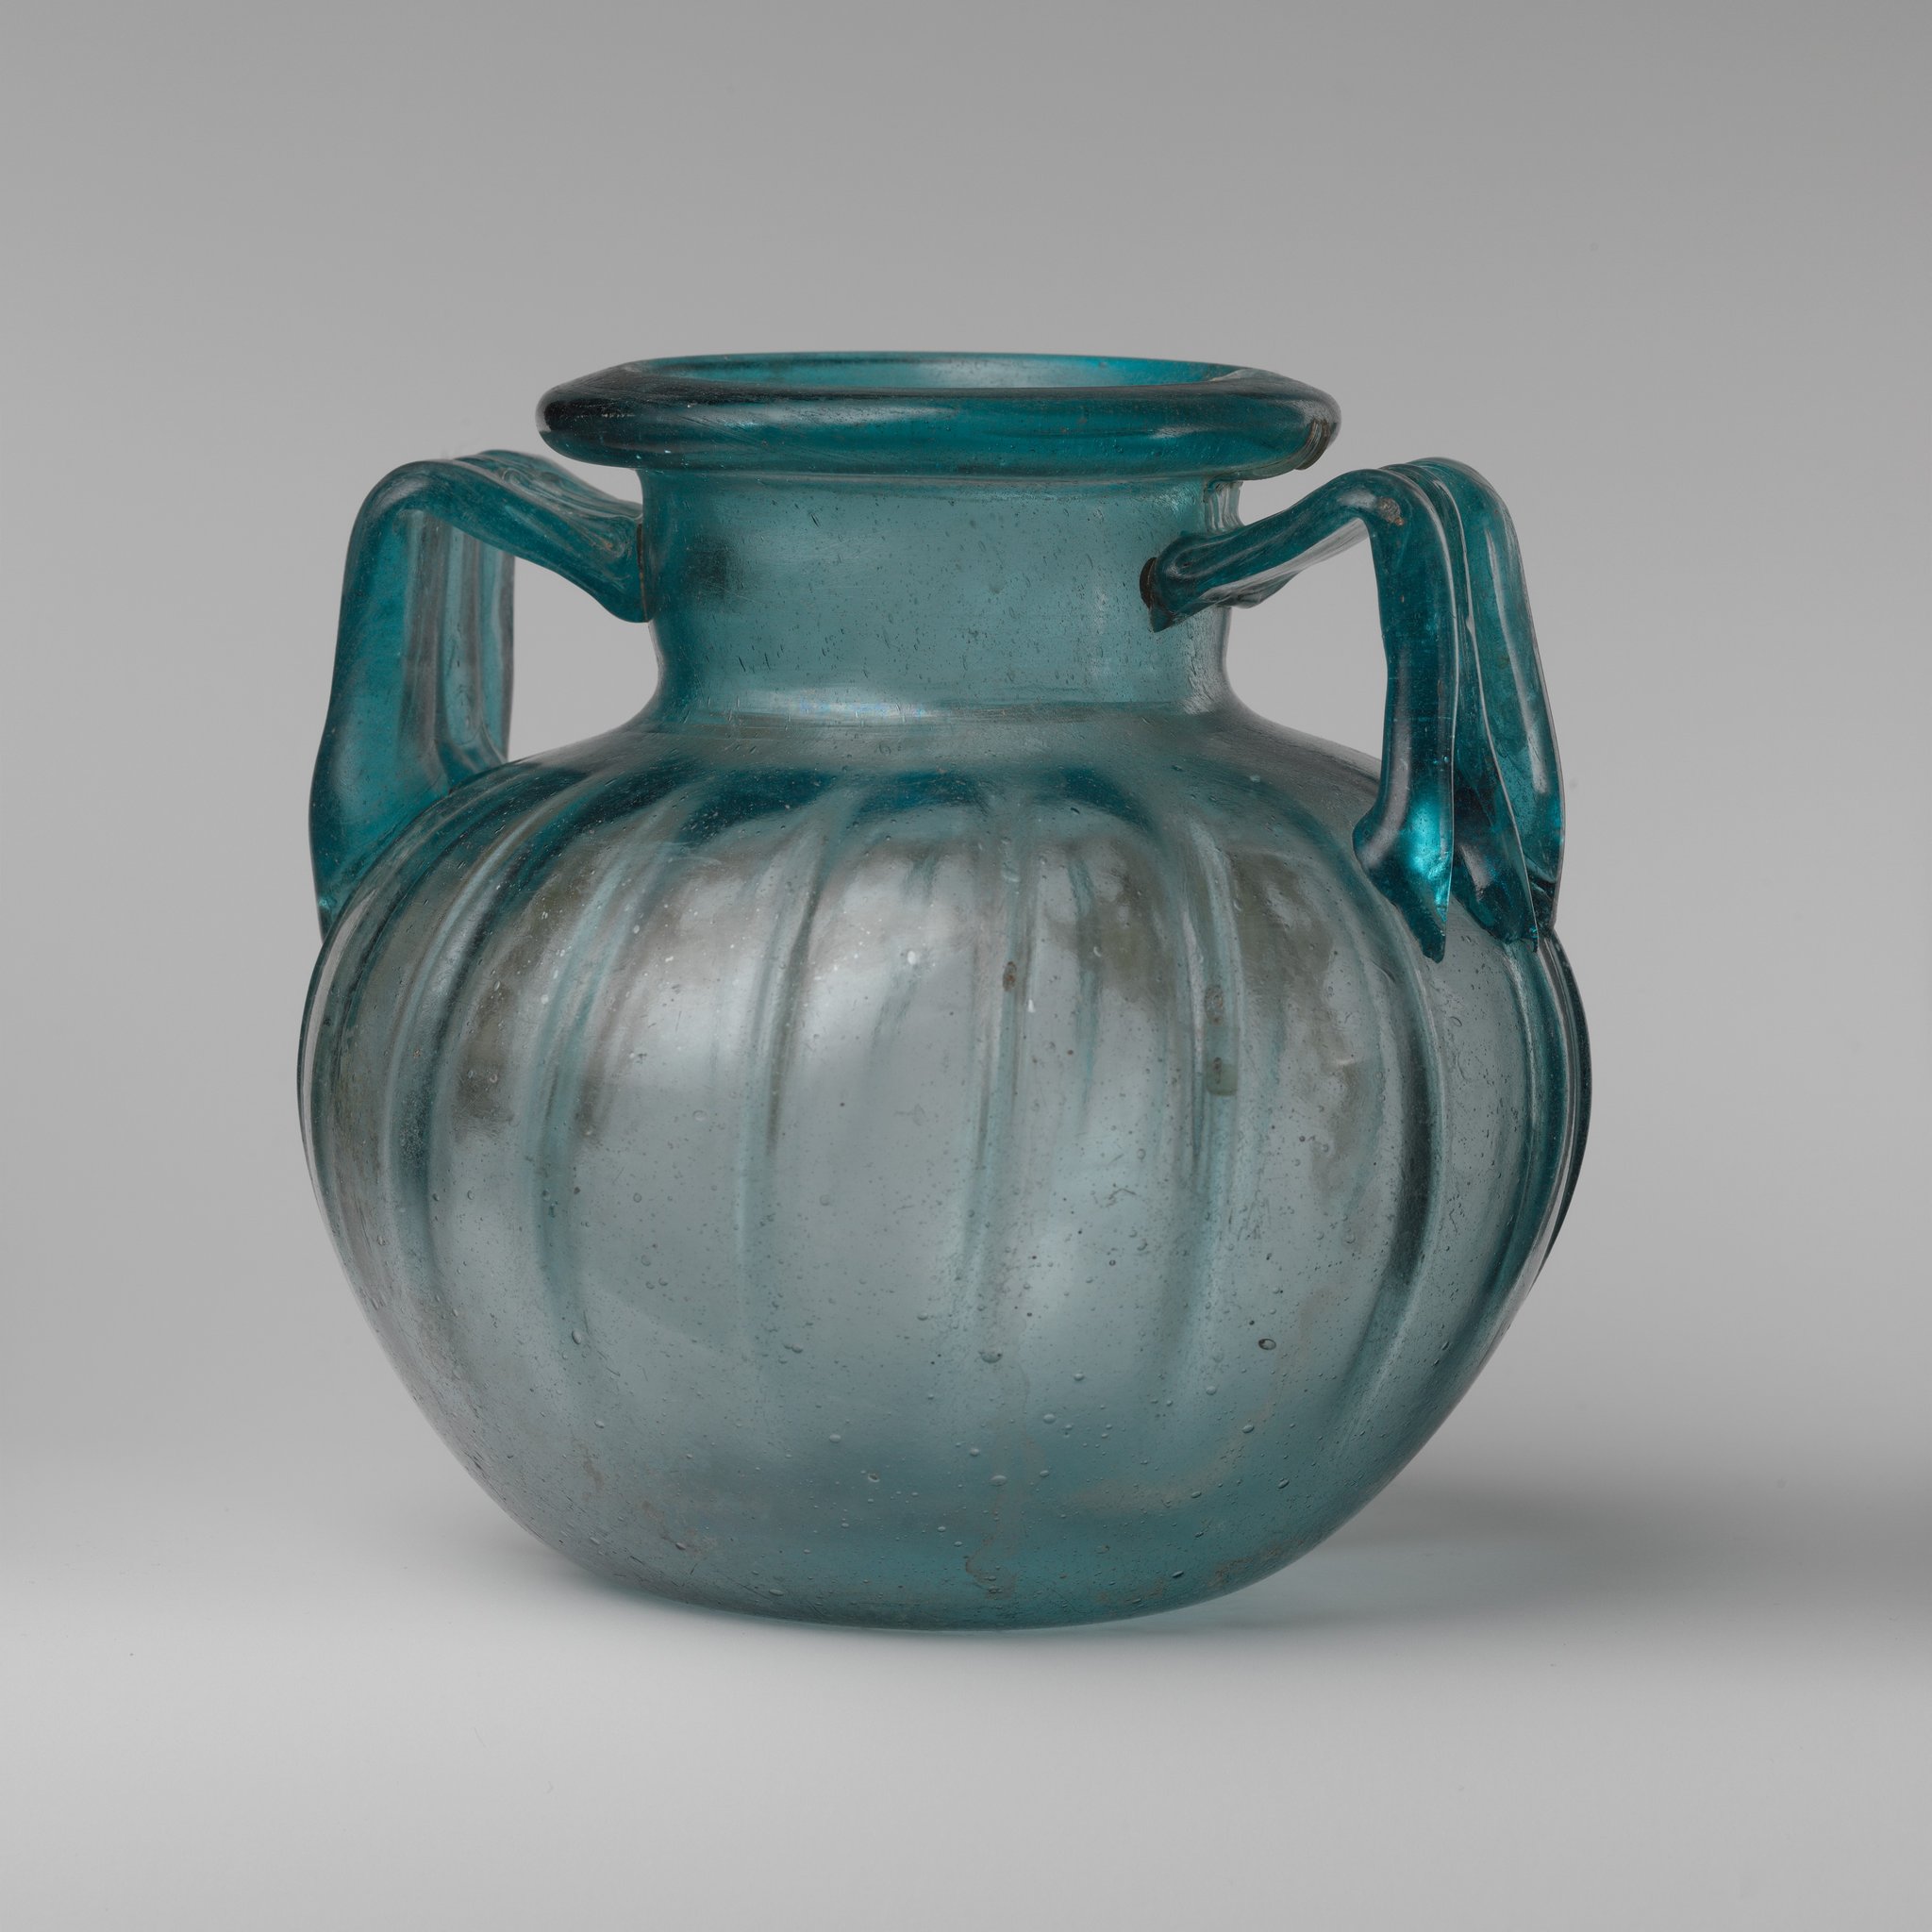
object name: jar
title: Glass two-handled jar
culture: roman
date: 1-300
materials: glass